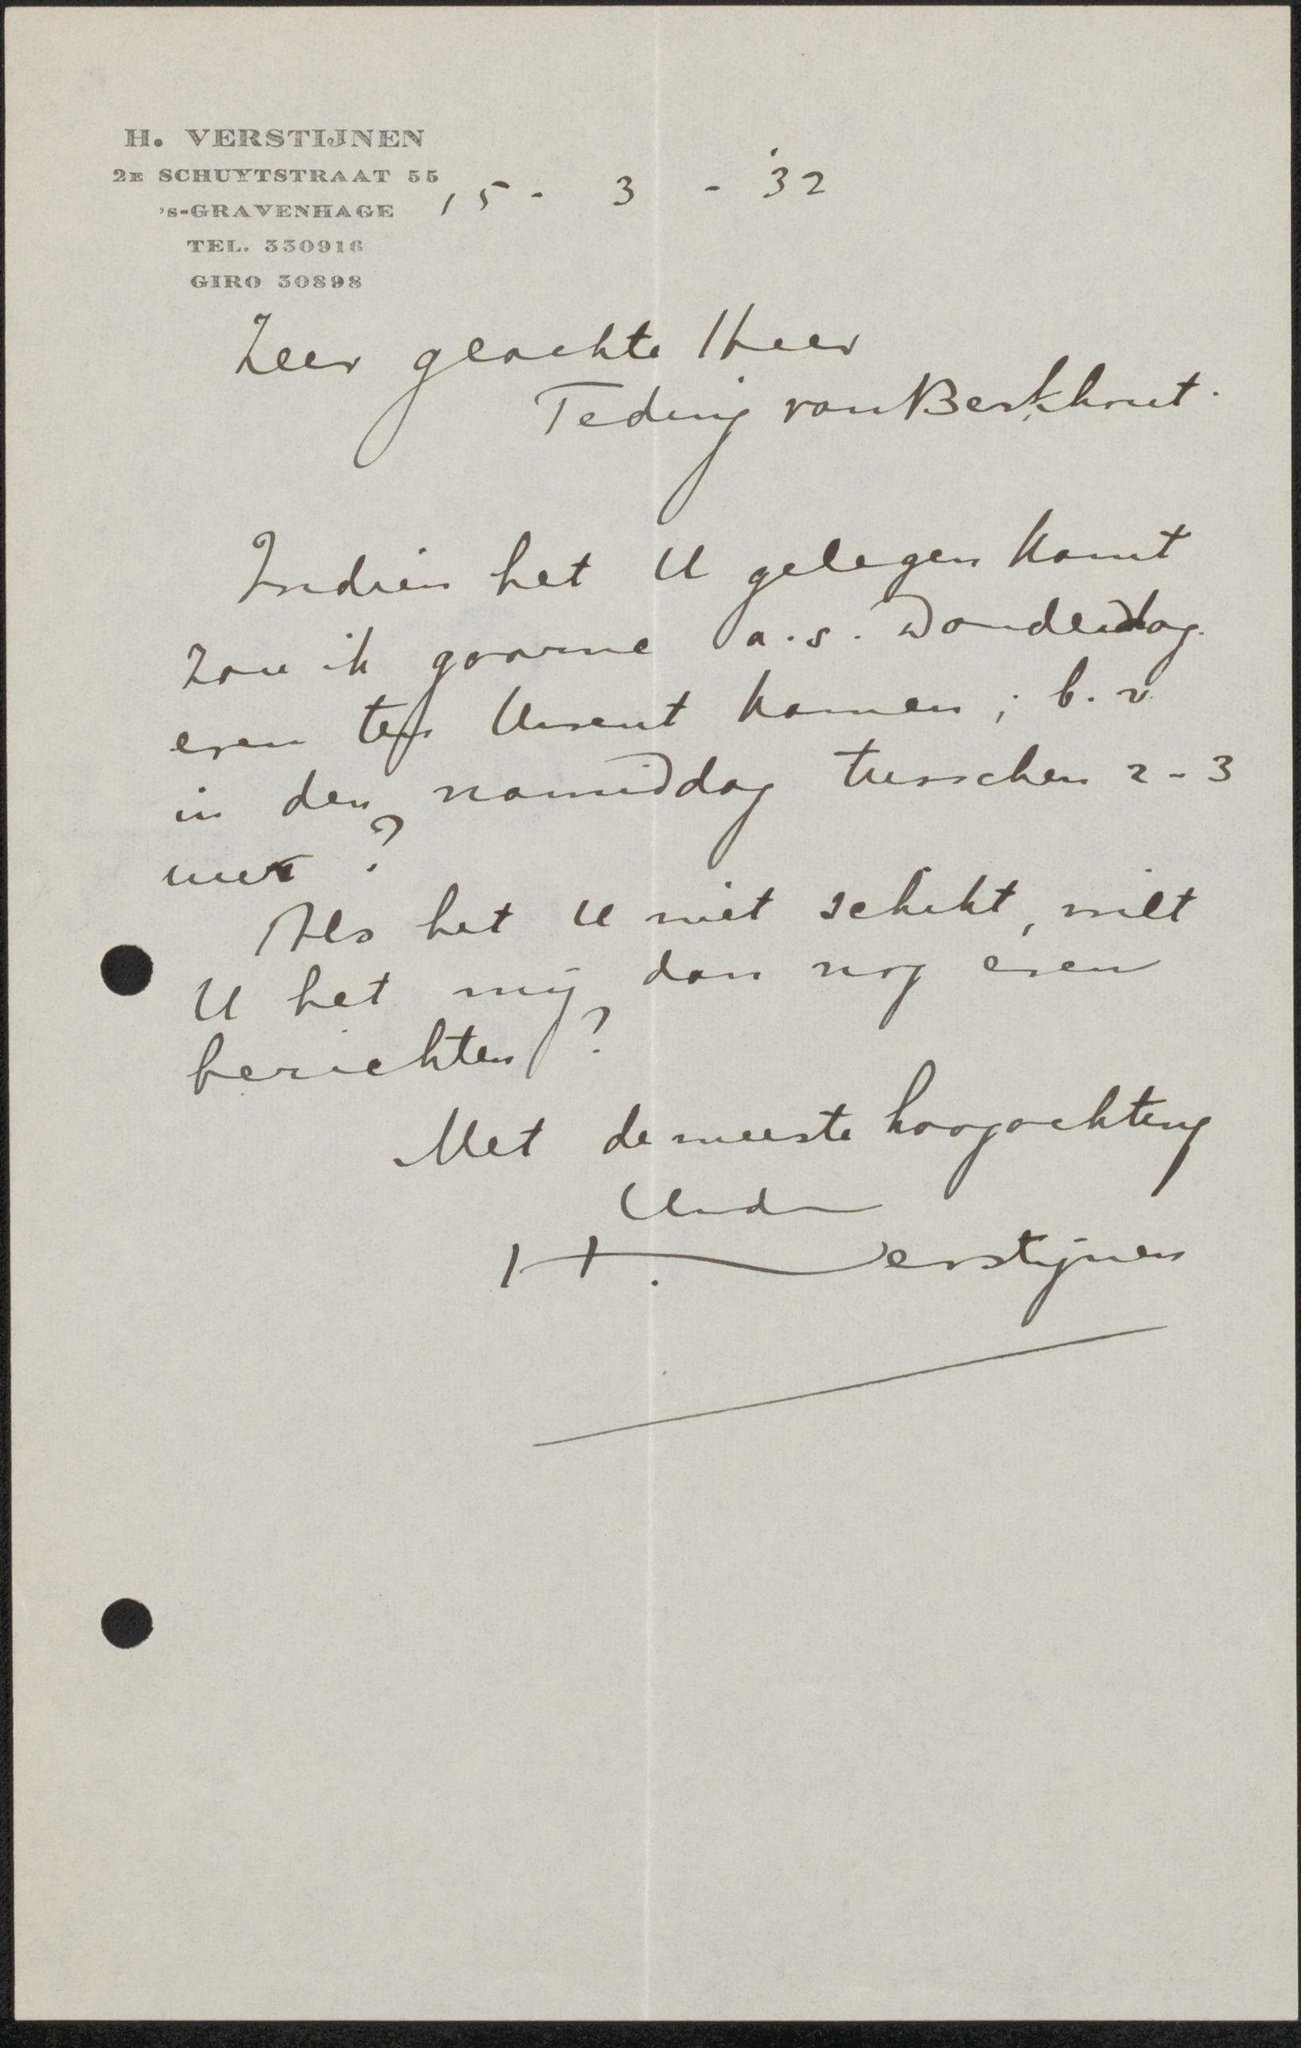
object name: letter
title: Brief aan jonkheer Hendrik Teding van Berkhout (1879-1969)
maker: henri verstijnen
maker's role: draughtsman, print maker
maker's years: 1882-1940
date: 1932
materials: ink, paper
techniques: pen, writing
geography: the hague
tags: haarlem, amsterdam, jonkheer hendrik teding van berkhout (1879-1969)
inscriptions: watermark